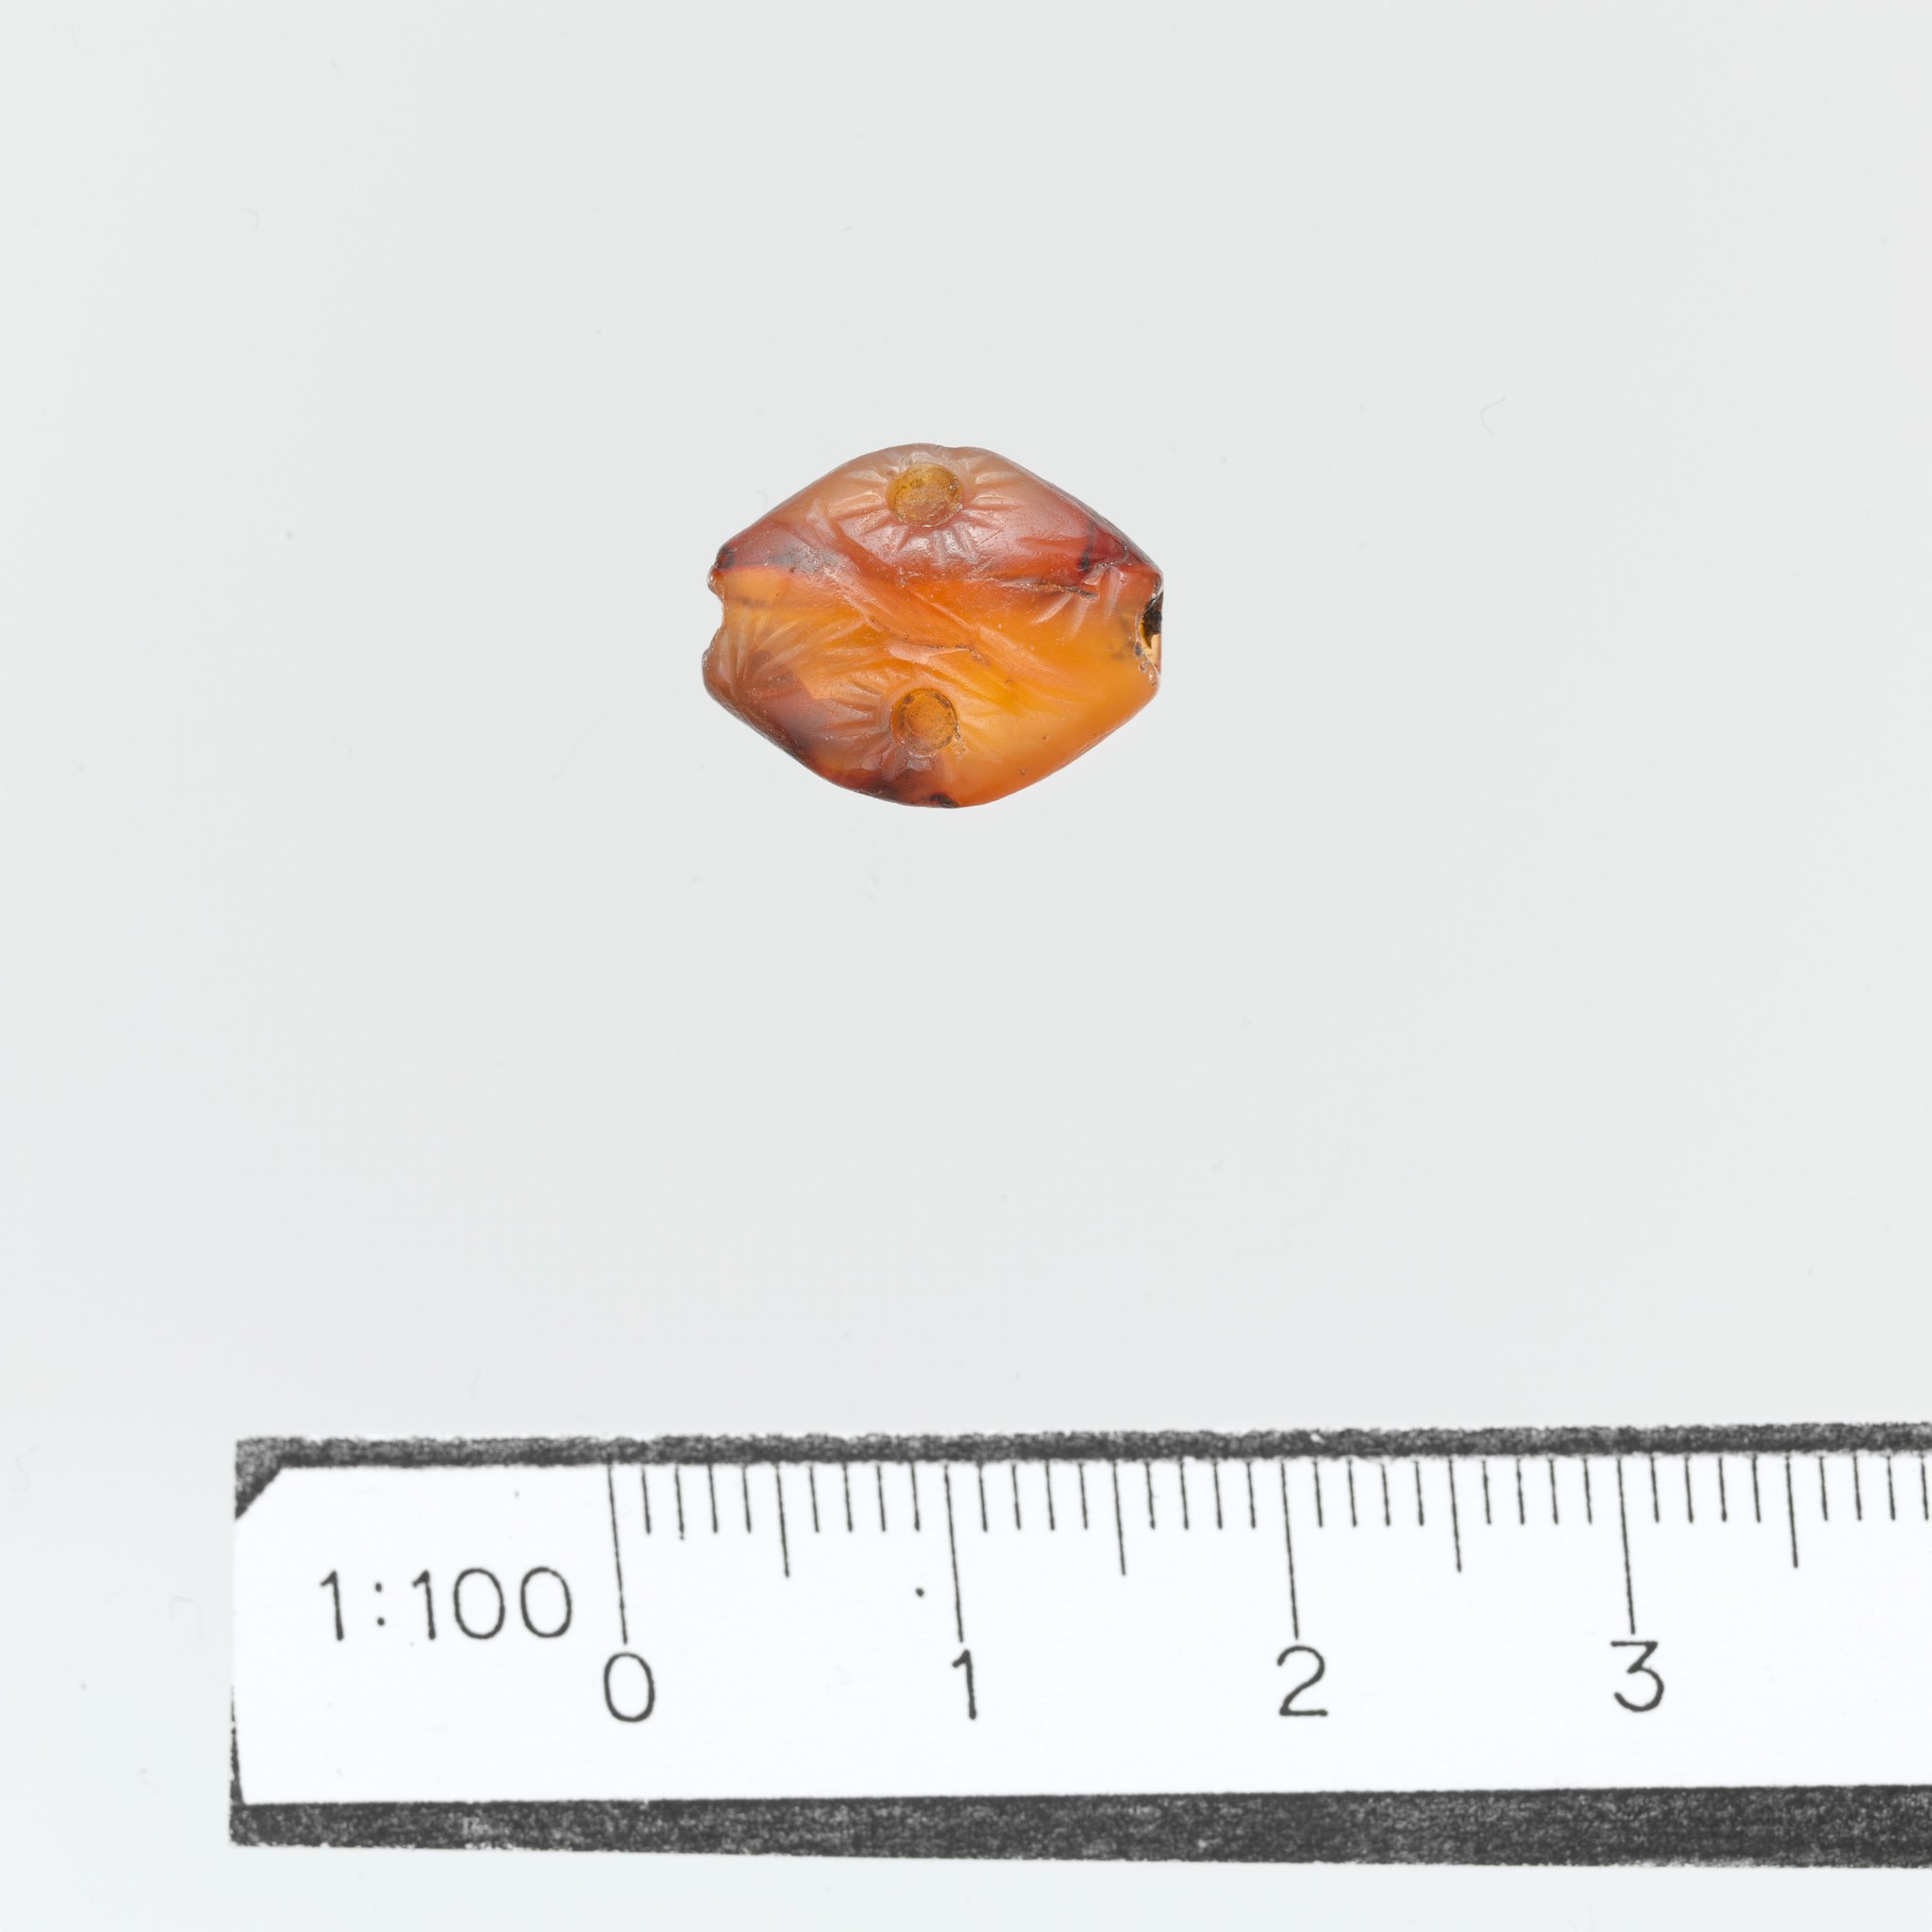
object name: seal, amygdaloid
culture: minoan, crete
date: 1650-1500 BCE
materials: gemstone